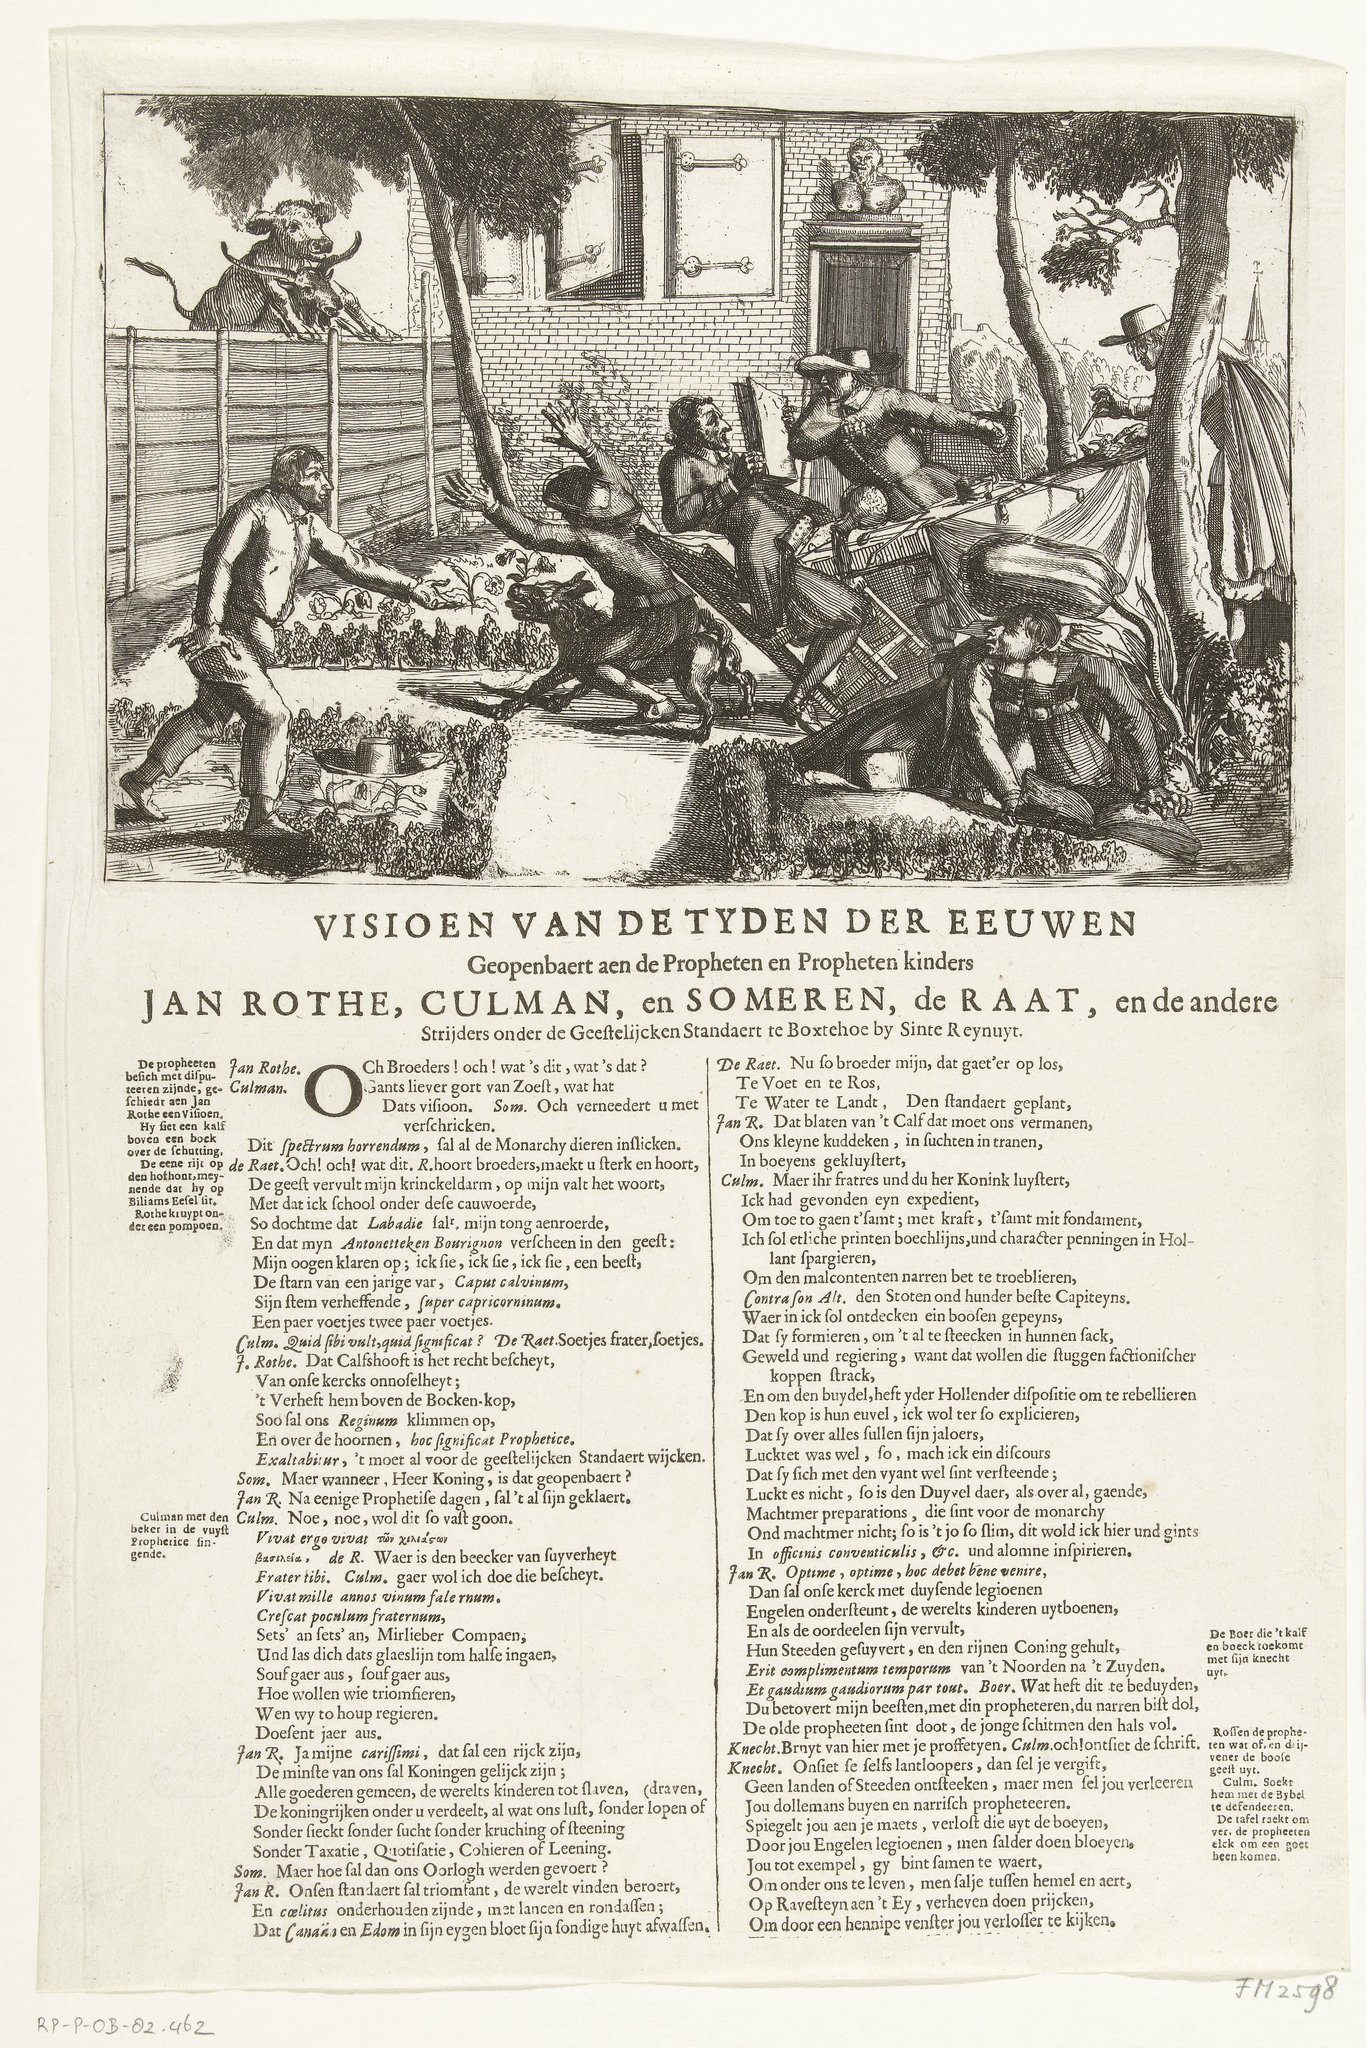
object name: print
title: Spotprent op Joannes Rothe, ca. 1676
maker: Anonymous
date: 1676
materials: paper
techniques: engraving, etching, letterpress printing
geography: northern netherlands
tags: animals (+ animals mating), quarrel, argument, fighting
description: Spotprent op de onderlinge strijd tussen Joannes Rothe en andere chiliasten, mystieke schrijvers en predikanten Koelman, Everard van Someren en Alhardt Johan de Raedt, ca. 1676. De zogenaamde profeten gaan rond een tafel in een tuin met elkaar op de vuist. Links wordt een toekijkende geit gedekt door een stier. Onder de prent een vers in 2 kolommen in een soort nepduits.